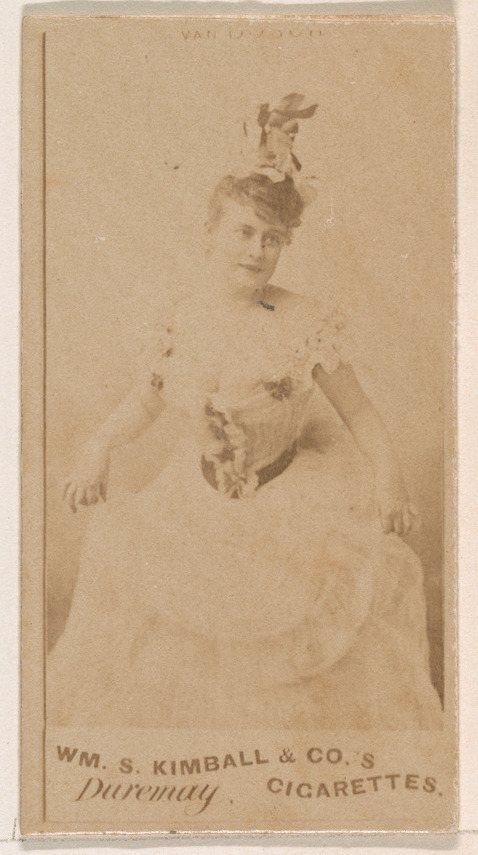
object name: photograph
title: Miss Duremay, from the Actresses series (N203) issued by Wm. S. Kimball & Co.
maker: william s. kimball & company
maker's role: publisher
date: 1889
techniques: color lithograph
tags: portraits,women,actresses